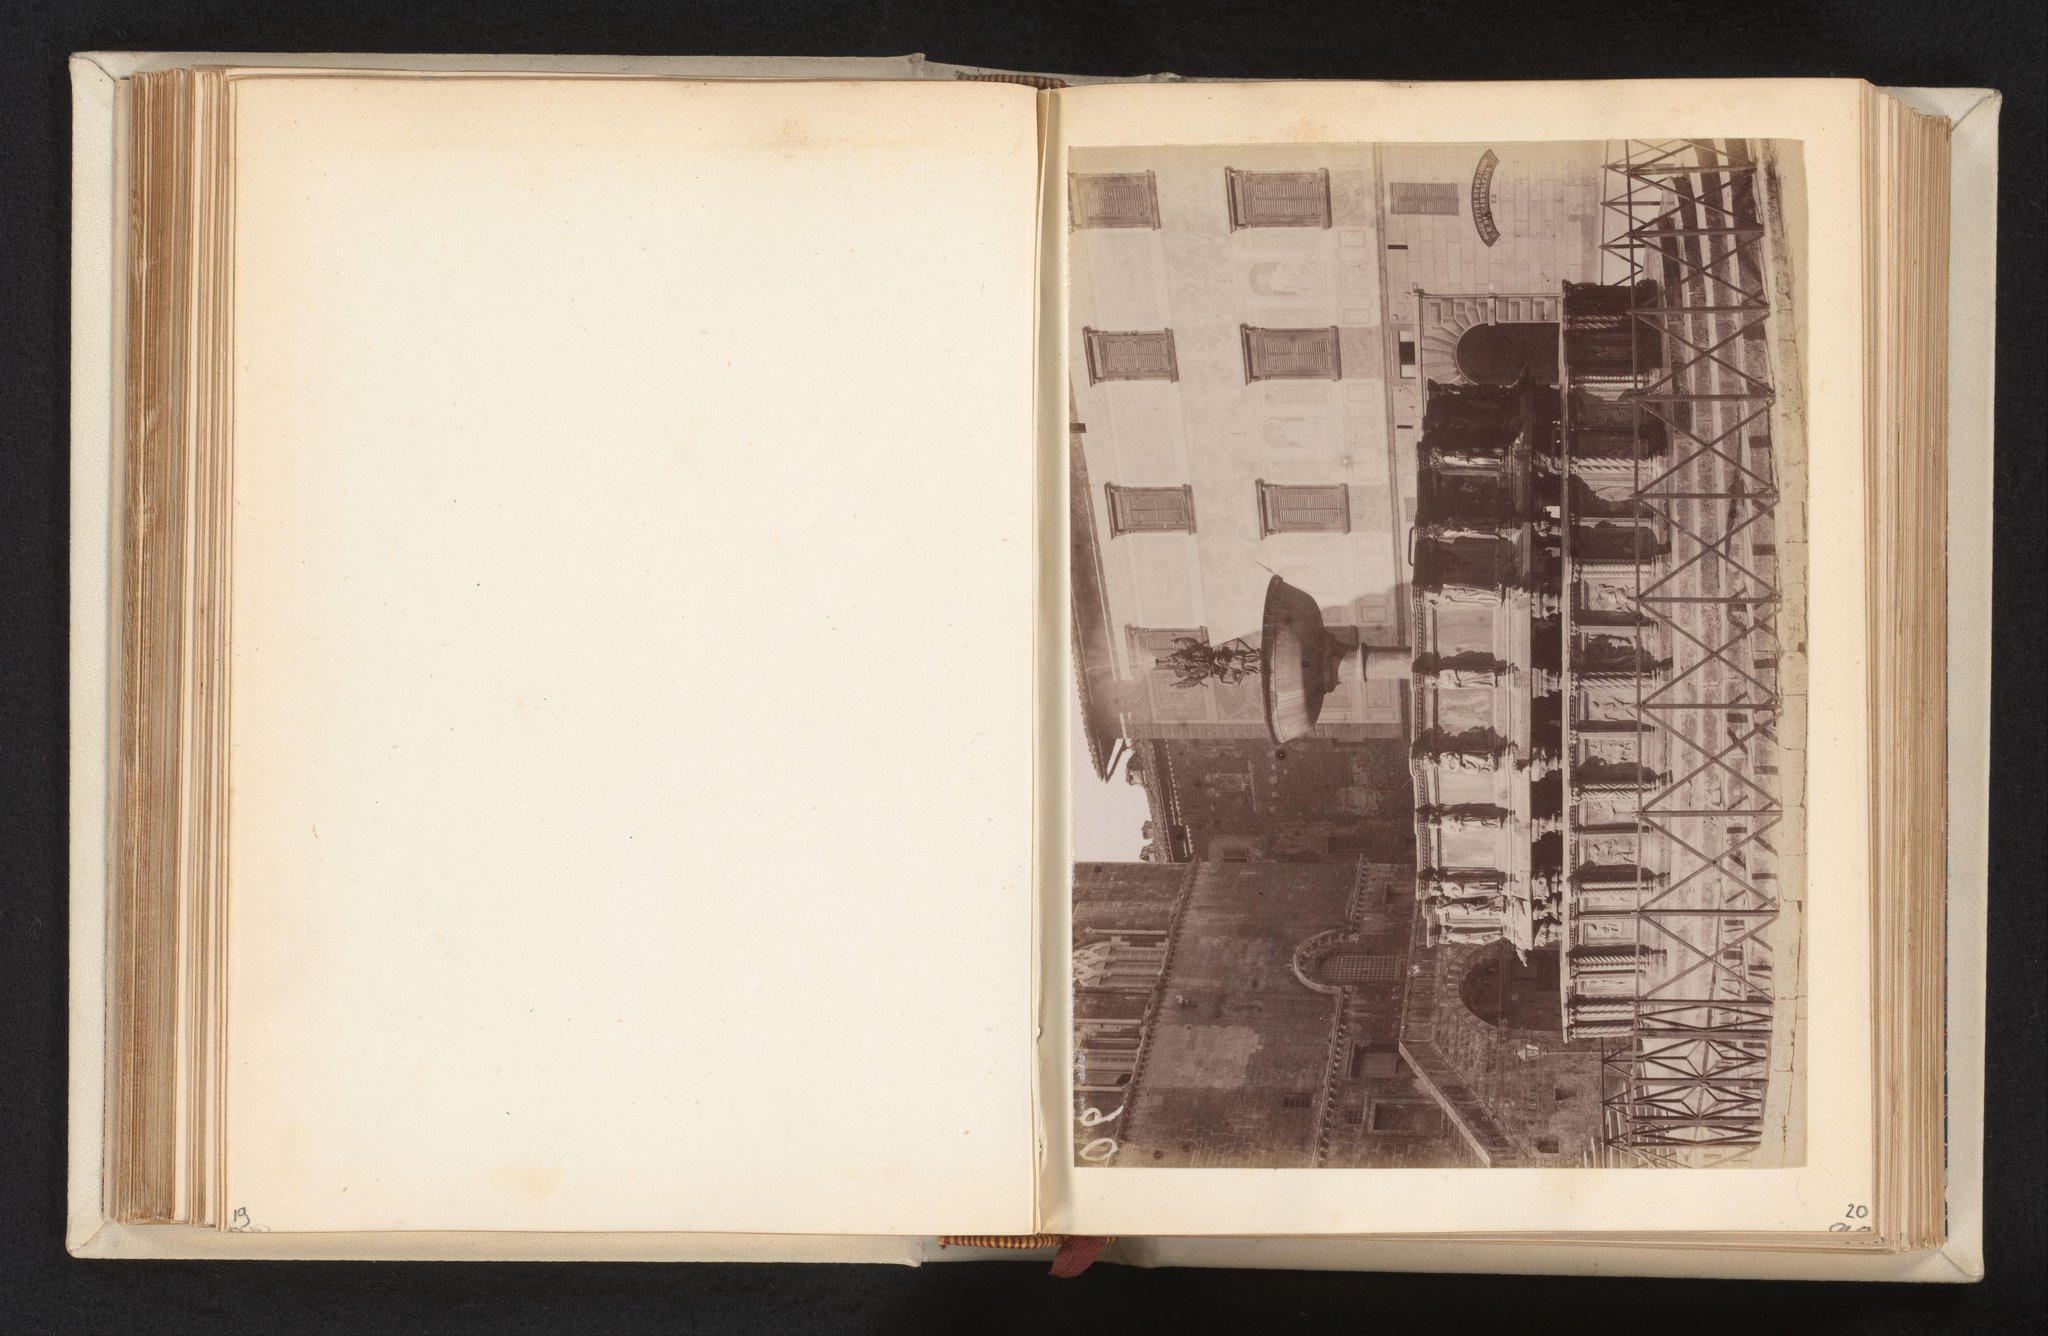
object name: page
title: Gezicht op de Fontana Maggiore in Perugia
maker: Anonymous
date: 1850-1860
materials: photographic support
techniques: albumen print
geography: perugia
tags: ornamental fountain